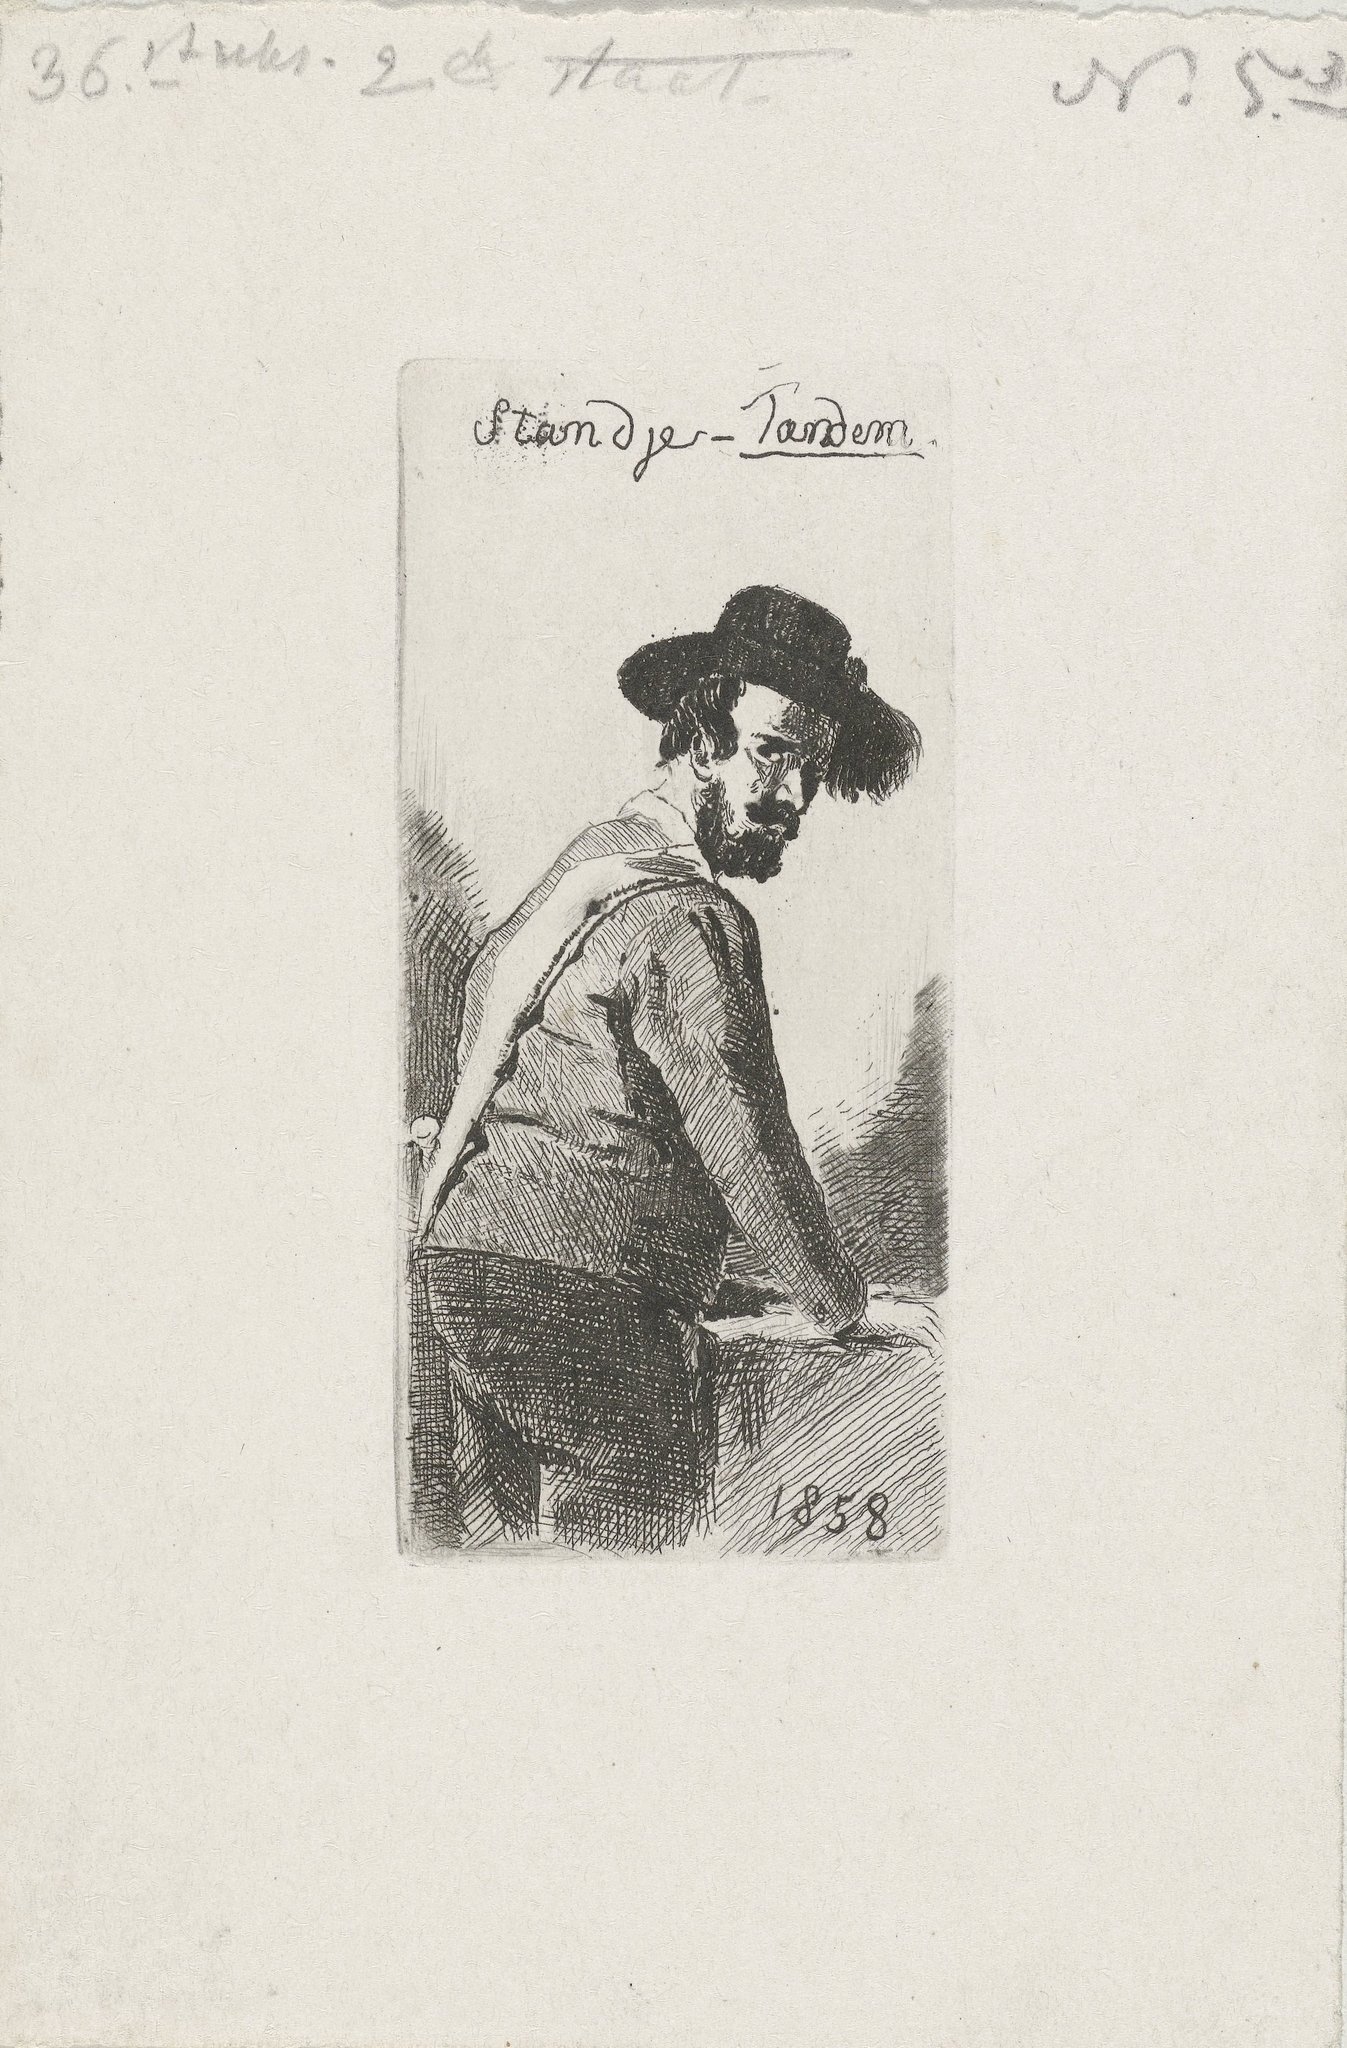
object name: print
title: Standje - Tandem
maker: cornelis van der griendt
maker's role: draughtsman, painter, print maker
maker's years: 1827-1918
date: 1858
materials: paper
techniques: etching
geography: delft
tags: standing figure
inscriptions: collector's mark: Lugt 2228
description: Figuurstudie van een man met hoed, kijkend over zijn rechterschouder.